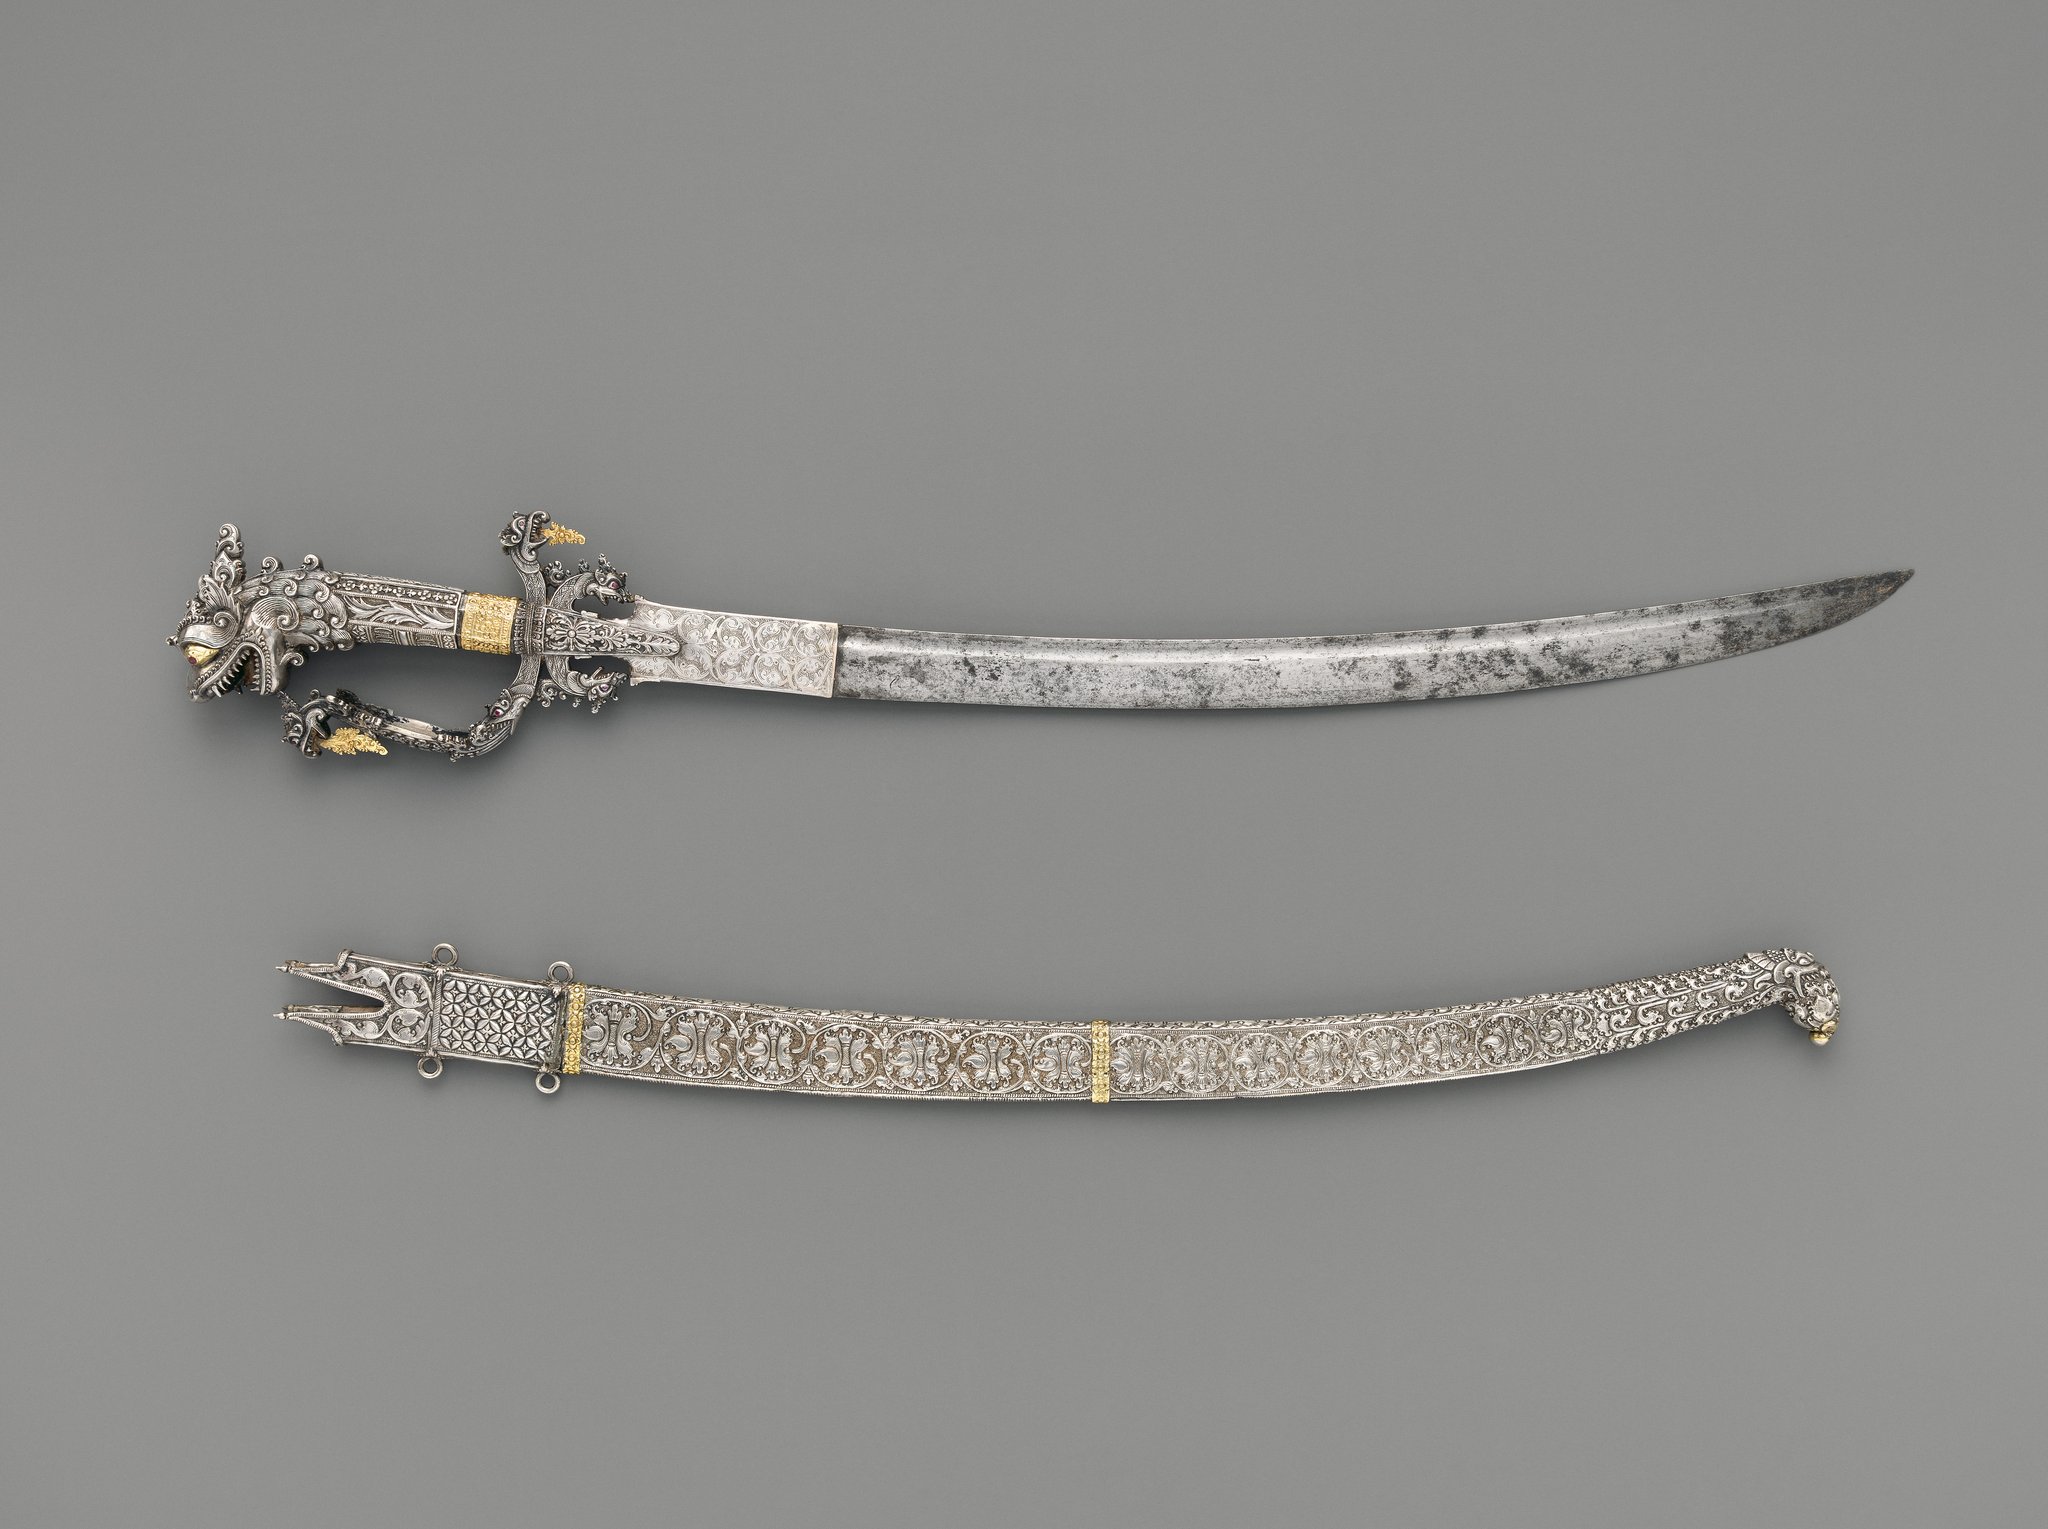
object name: sword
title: Sword and scabbard (Sinhalese: kasthane)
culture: sri lankan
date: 1701-1800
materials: gold, iron, silver, wood